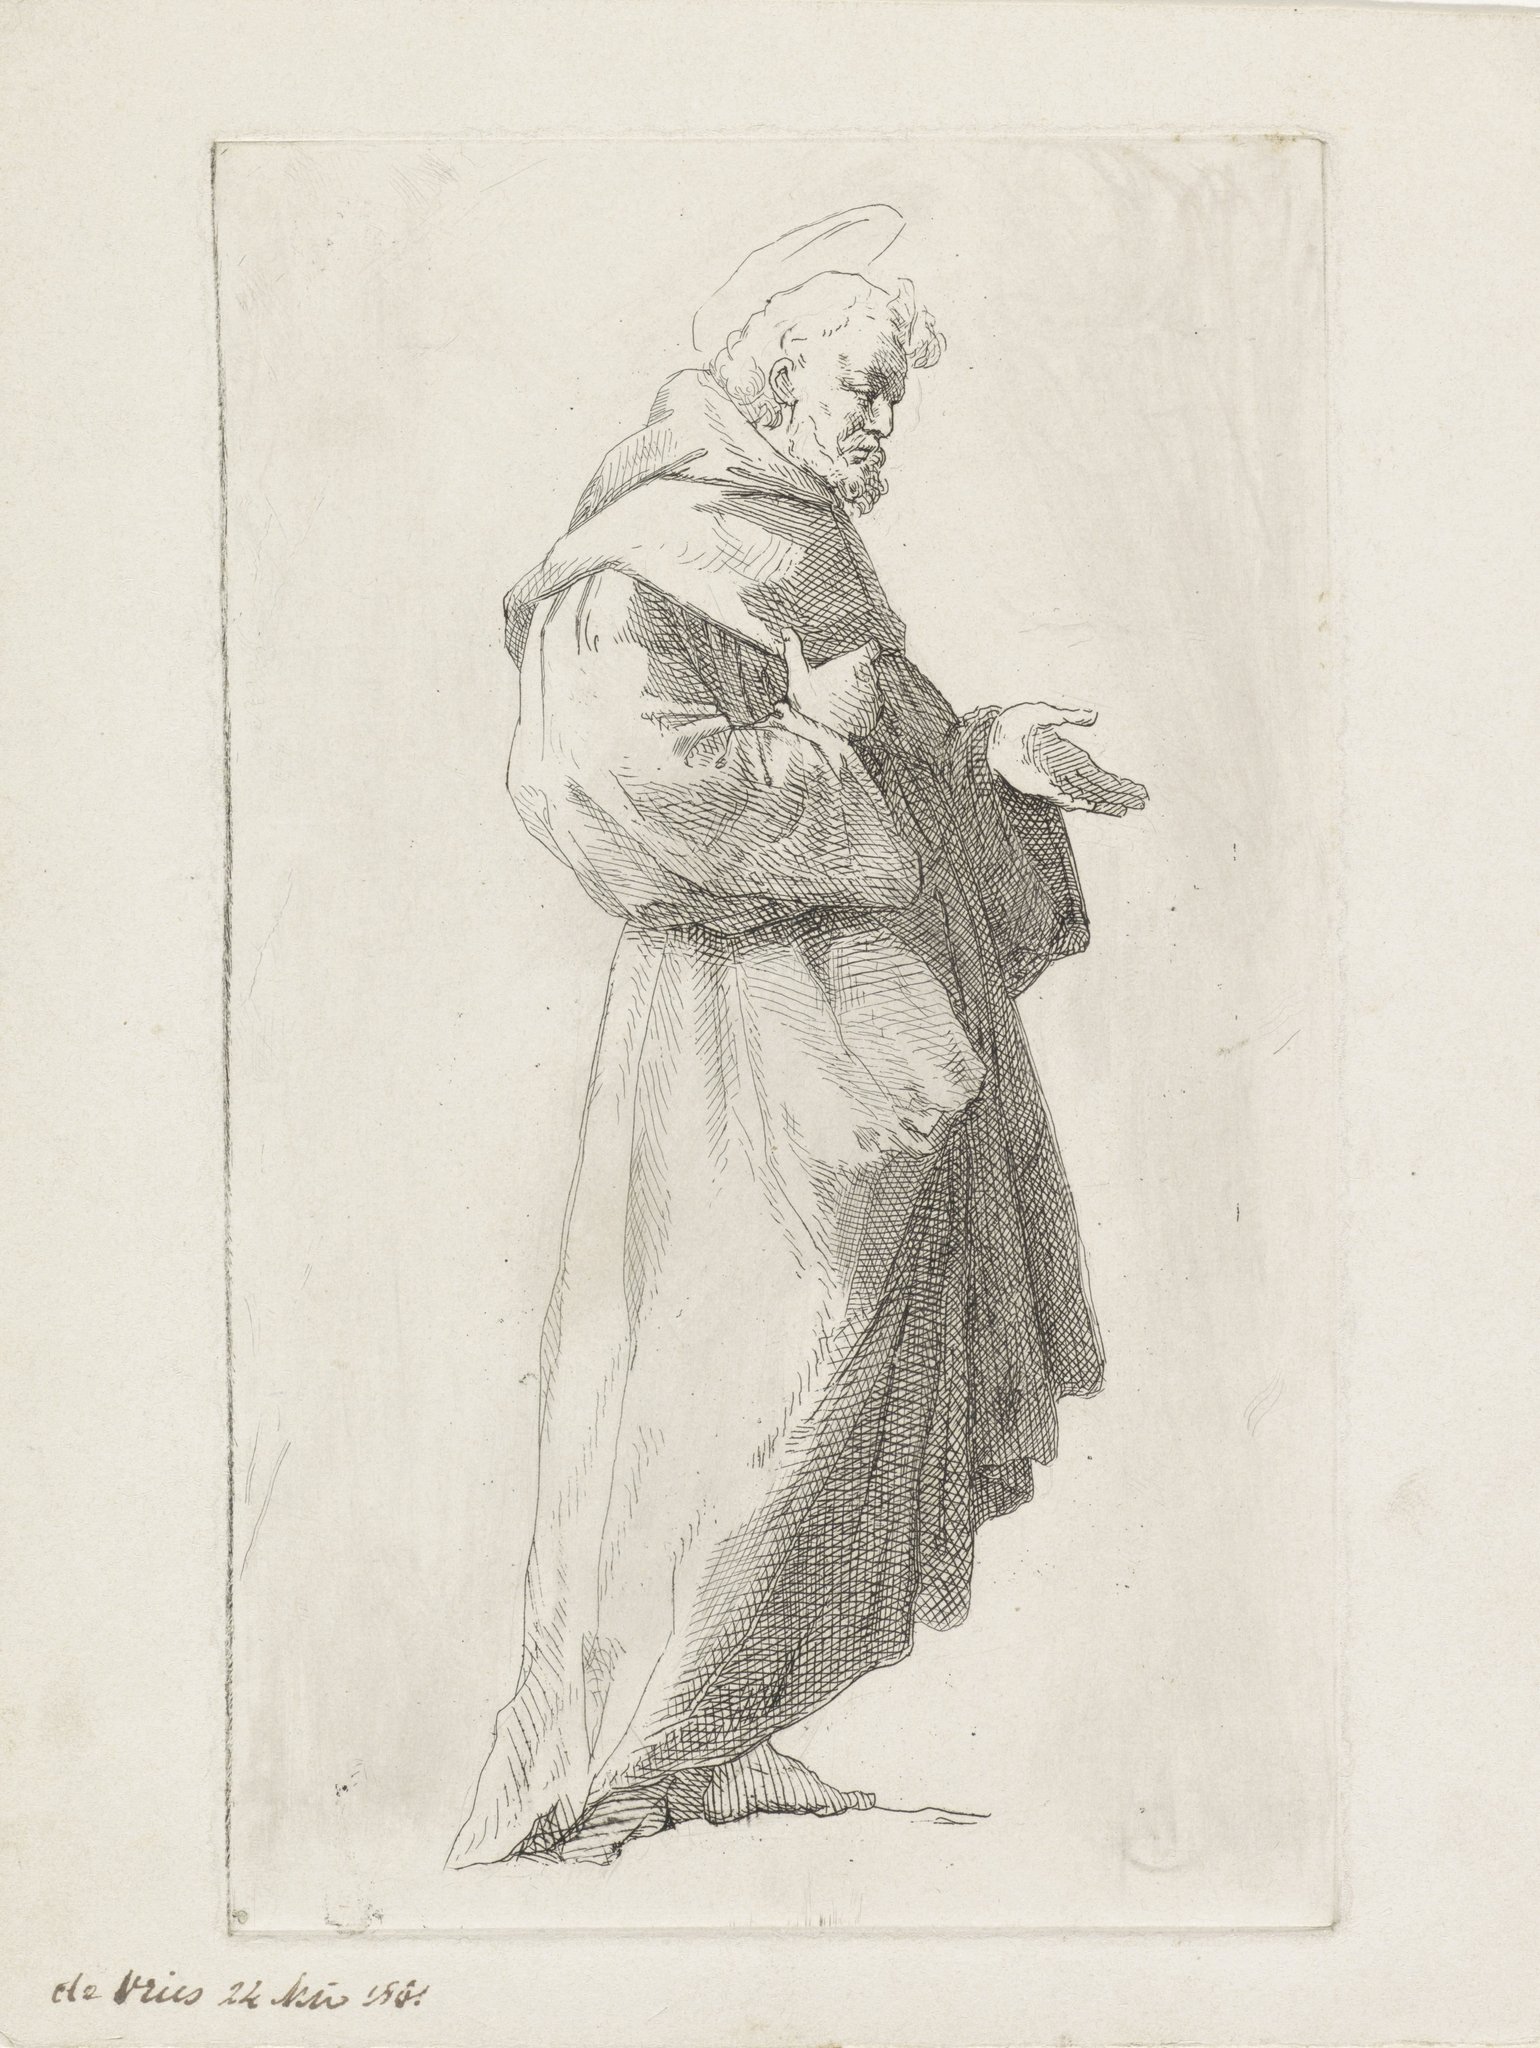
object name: print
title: Staande heilige in monnikspij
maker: de vries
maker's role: print maker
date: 1861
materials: paper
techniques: etching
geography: netherlands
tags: saints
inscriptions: collector's mark: Lugt 2228